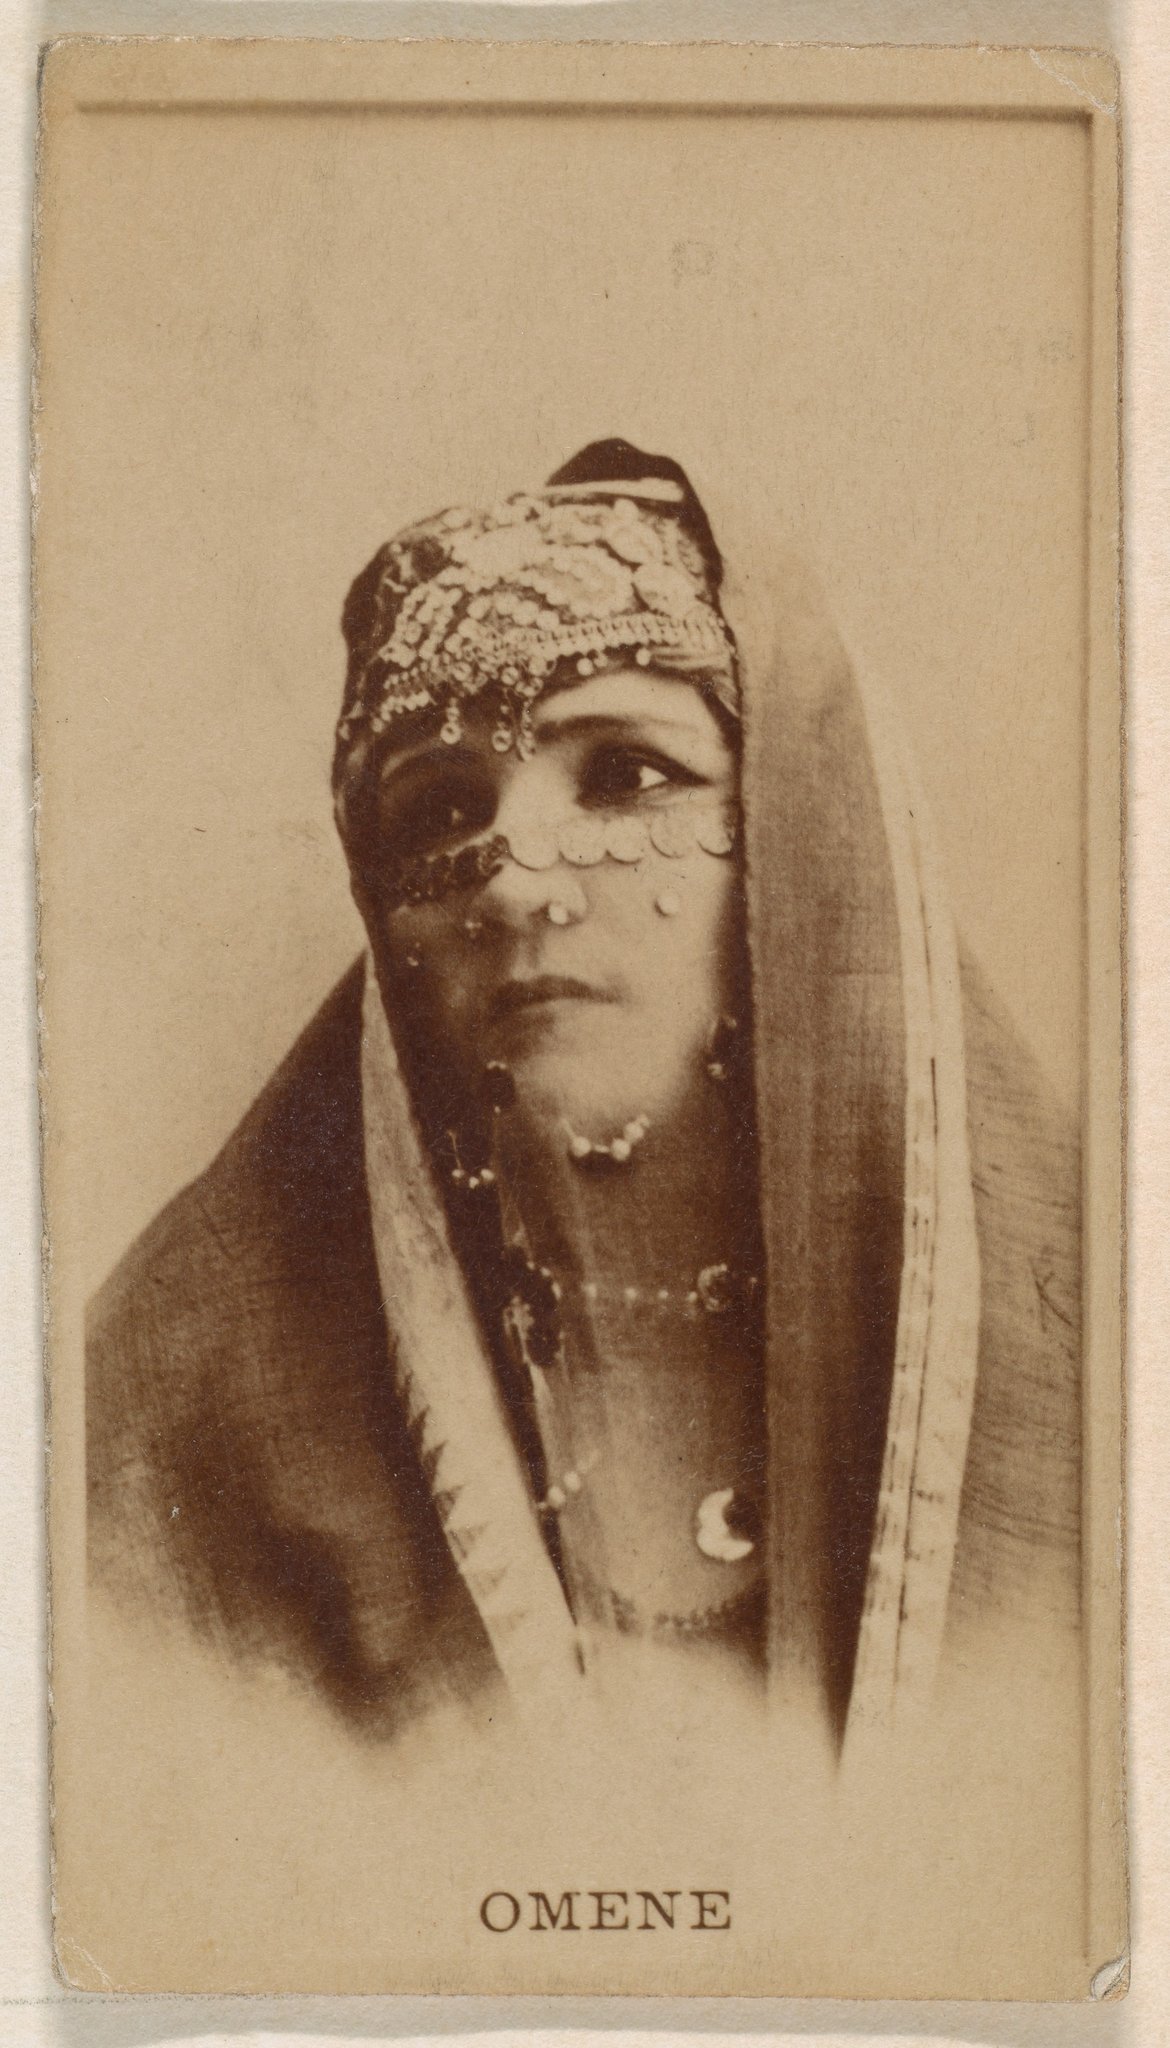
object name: photograph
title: Omene, from the Actresses series (N245) issued by Kinney Brothers to promote Sweet Caporal Cigarettes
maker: kinney brothers tobacco company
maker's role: publisher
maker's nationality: american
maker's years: 1869-2011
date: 1890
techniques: albumen silver print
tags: portraits,women,actresses